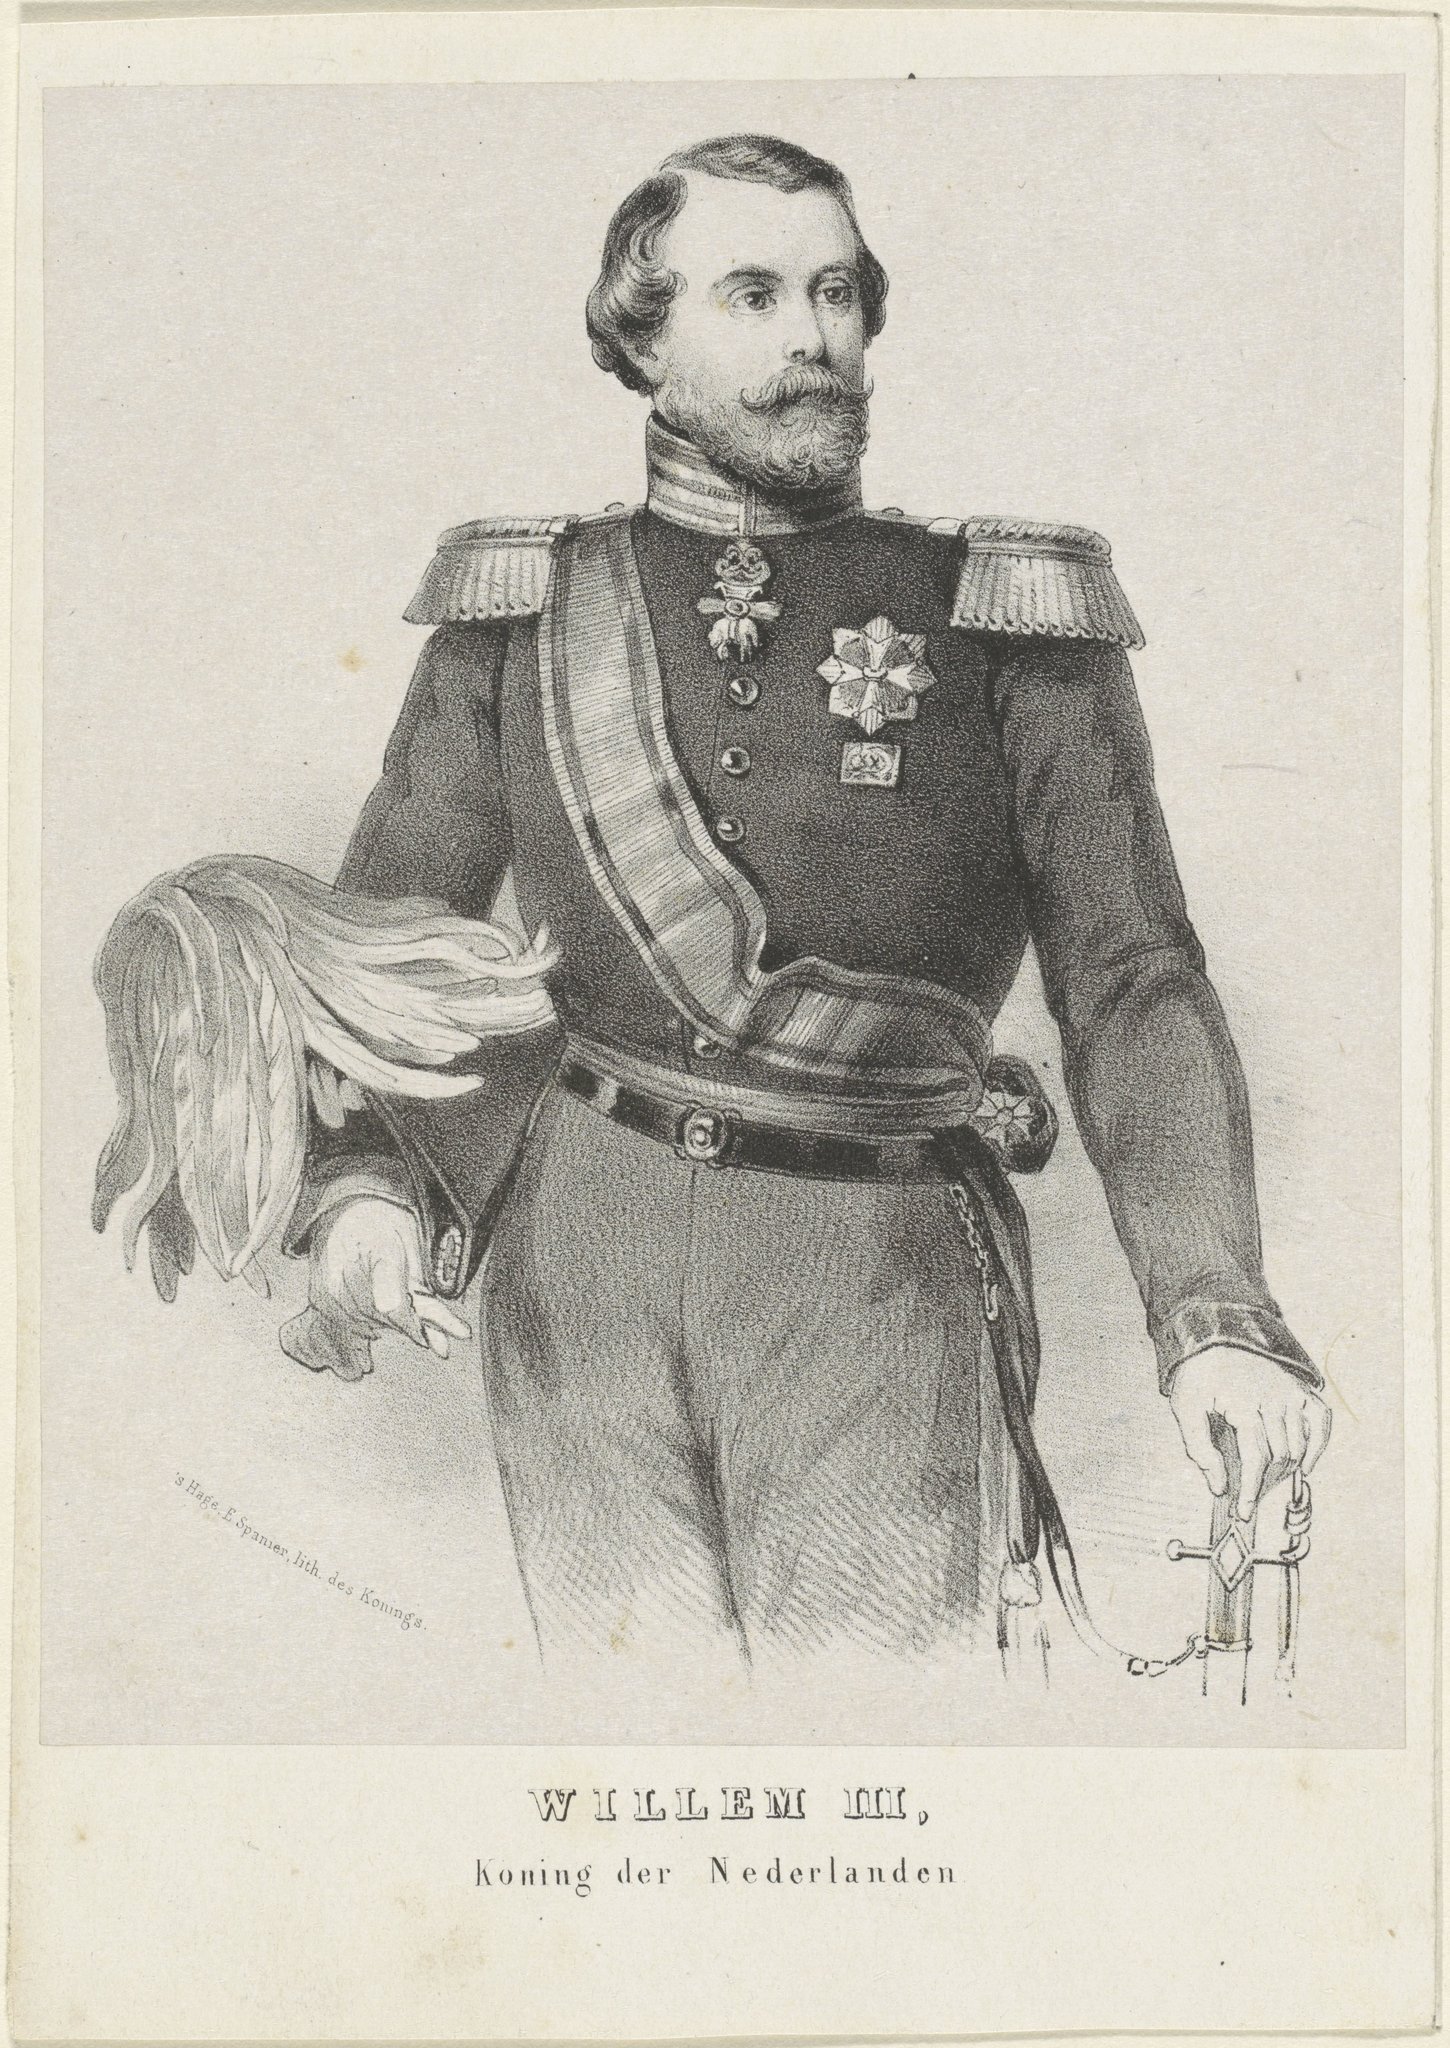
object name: print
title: Portret van Willem III, koning der Nederlanden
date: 1849-1863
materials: paper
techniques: lithograph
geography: netherlands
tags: brussels, willem iii (koning der nederlanden), knighthood order (garter) - insignia of a knighthood order, e.g.: badge, chain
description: De hier vermelde titel verwijst naar de hoogst verkregen titel van de geportretteerde, niet per se naar de titel die de geportretteerde op deze voorstelling draagt.